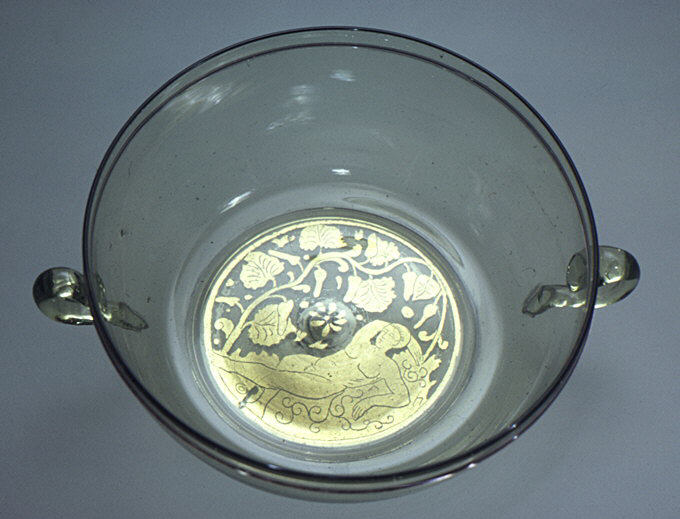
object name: bowl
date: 1801-1900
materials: glass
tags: male nudes